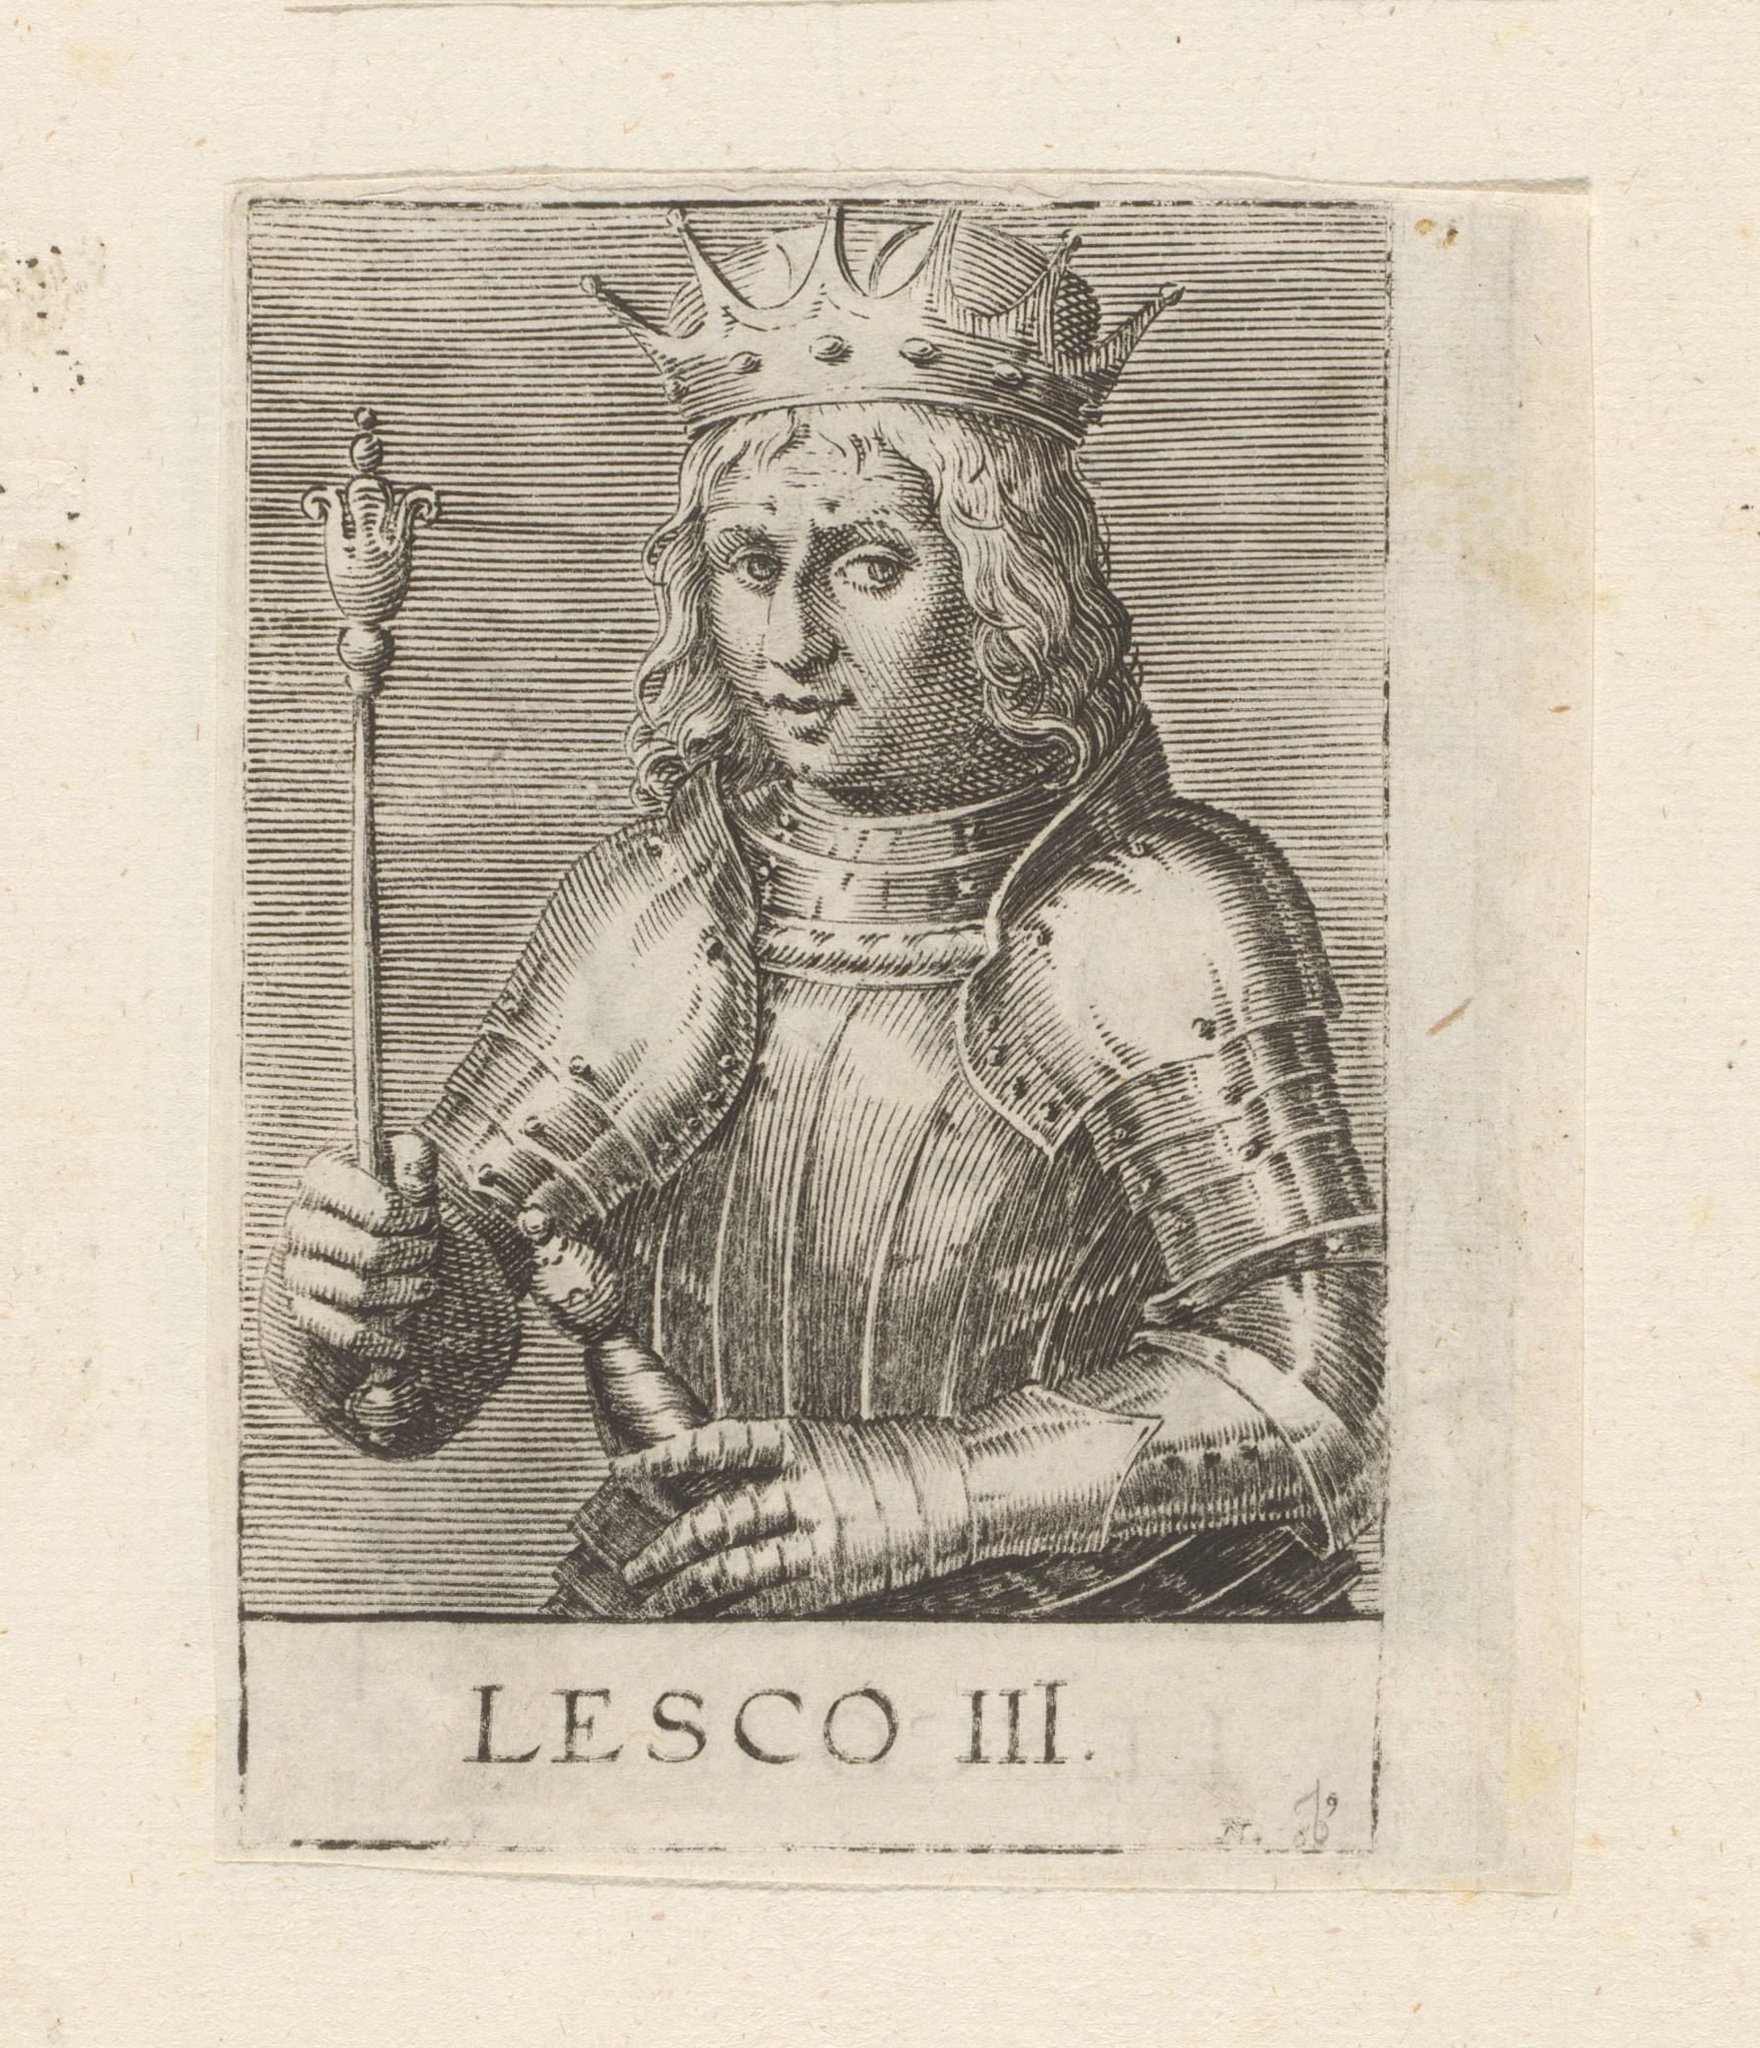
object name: album leaf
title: Portret van Leszko III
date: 1574-1594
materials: paper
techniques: woodcut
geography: cologne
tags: historical persons, king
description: Prent gebruikt in: Mylius, Arnold. Principum et Regum Polonorum Imagines ad Vivum Expressae (...). Keulen: Gottfried von Kempen, 1594.